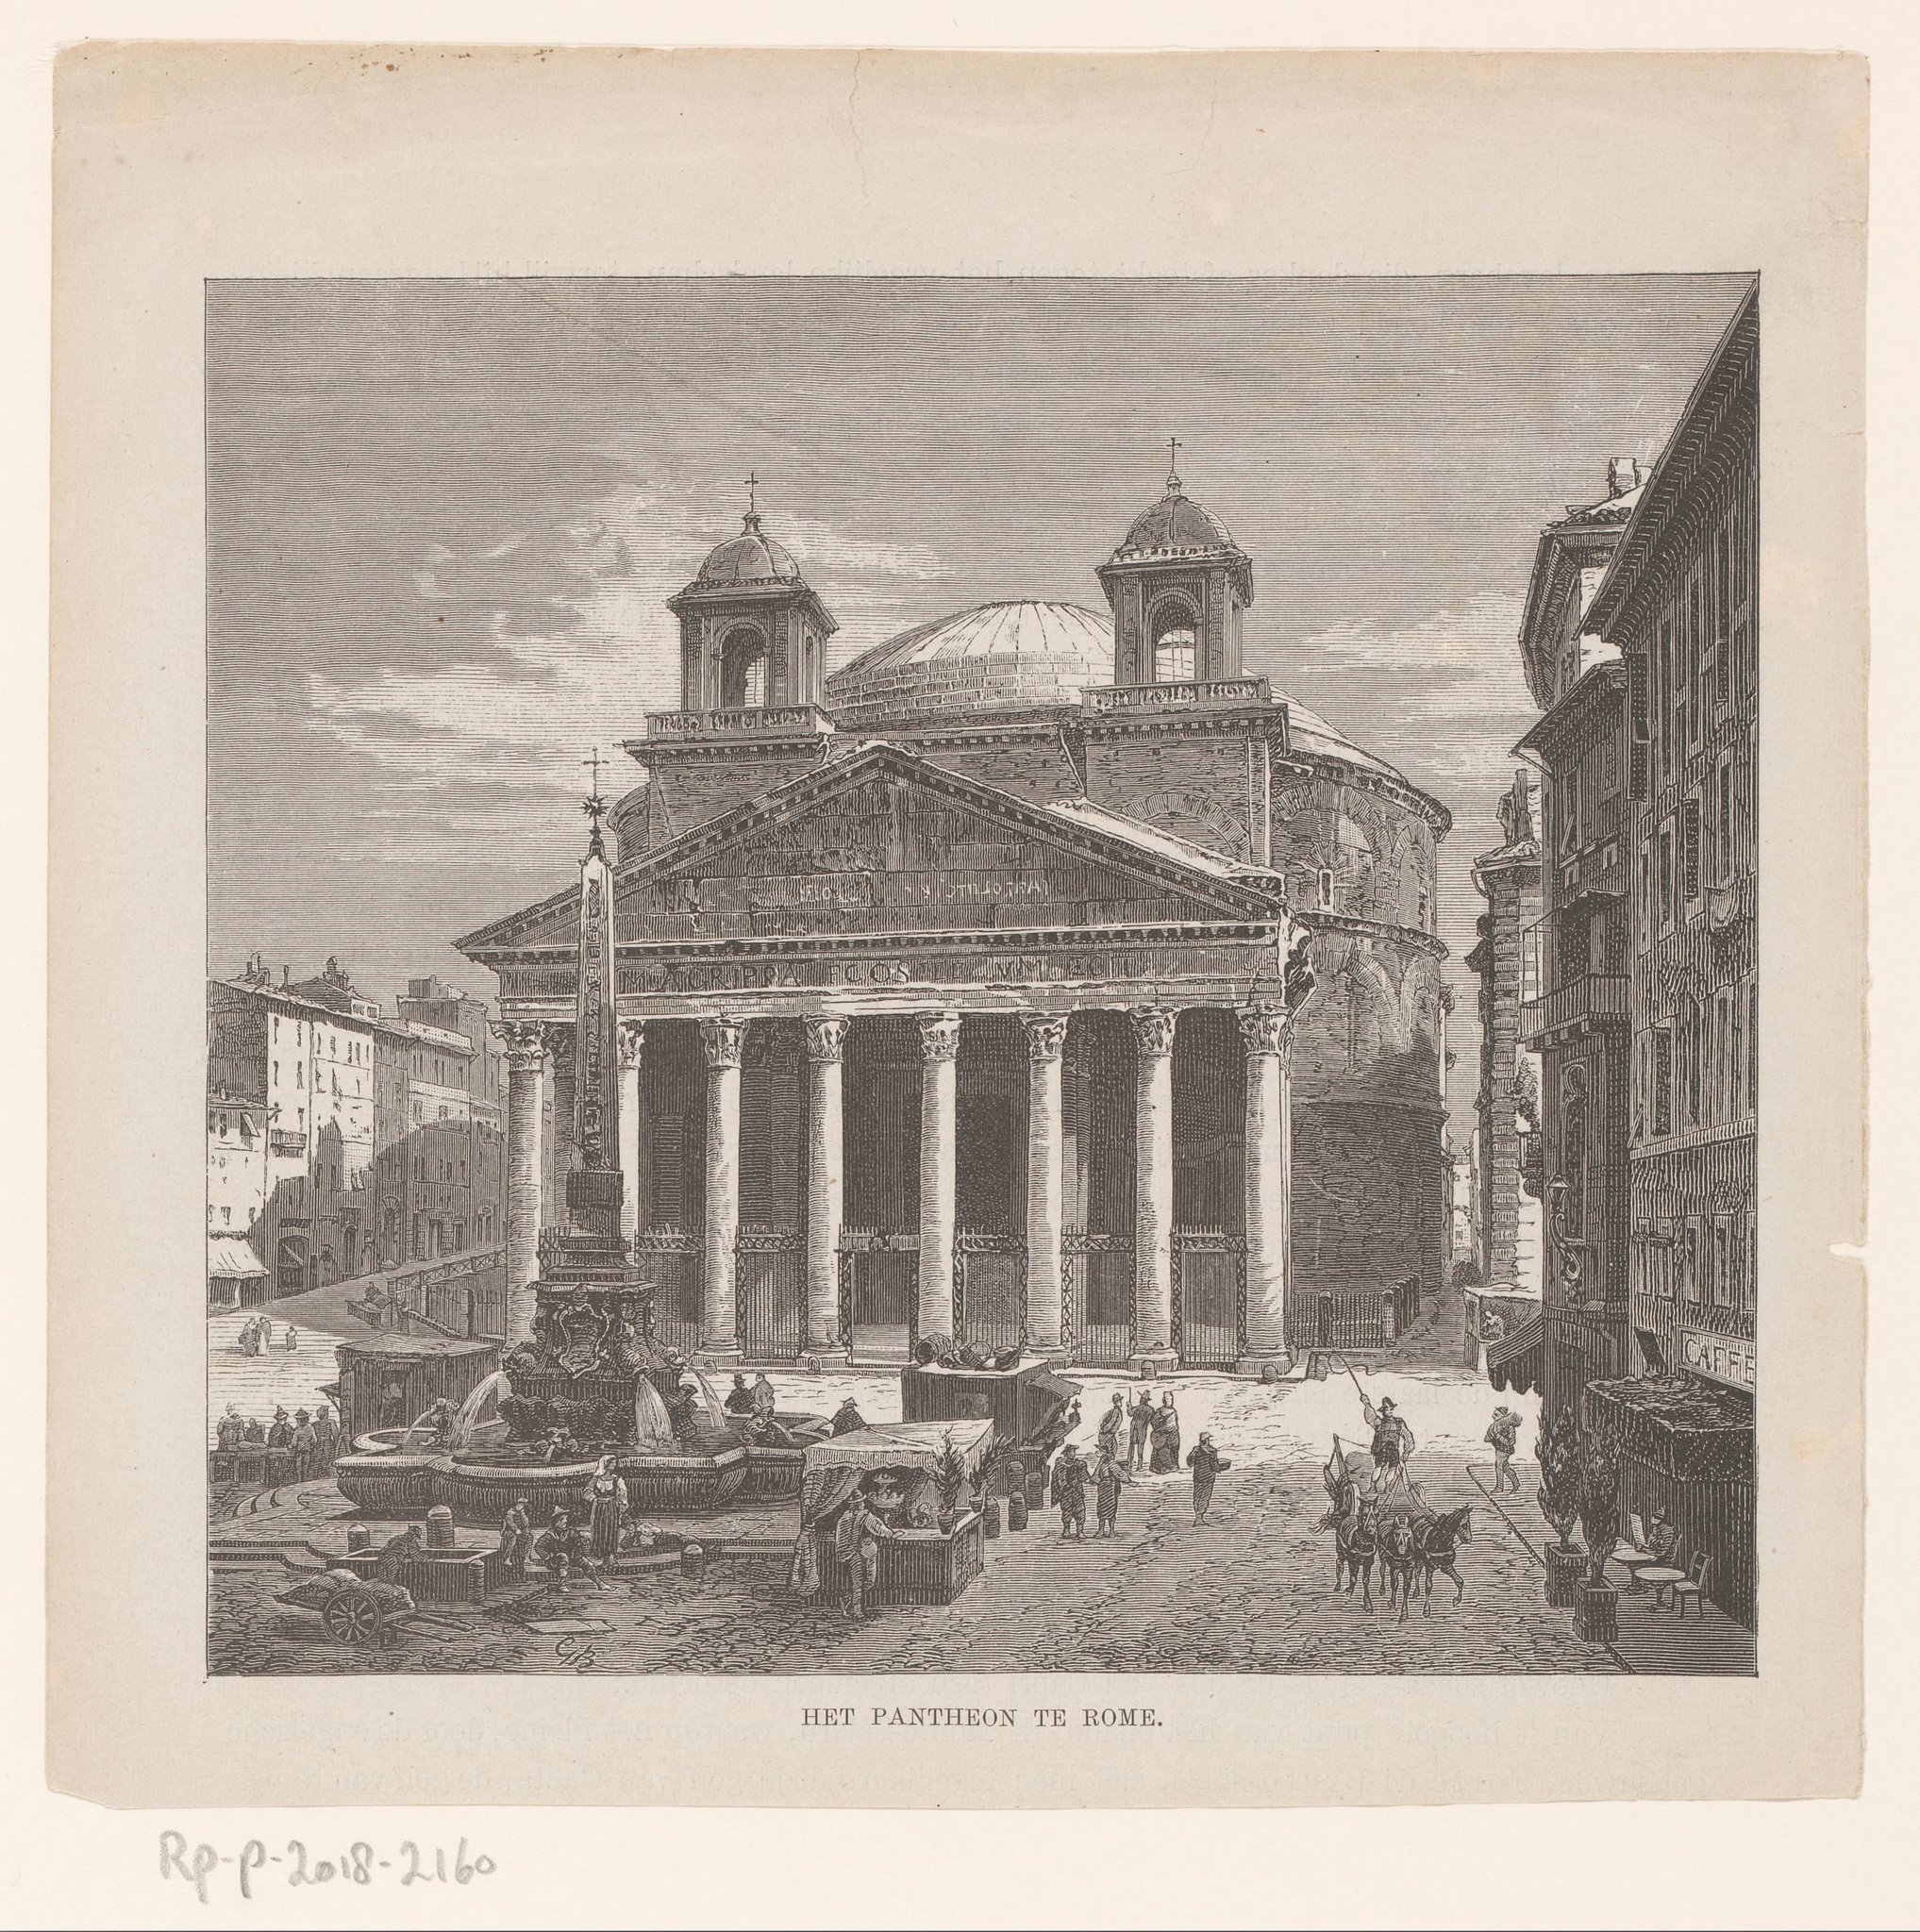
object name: print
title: Gezicht op het Pantheon, te Rome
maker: gustav bauernfeind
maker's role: draughtsman, print maker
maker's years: 1848-1904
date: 1880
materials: paper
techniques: engraving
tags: temple, shrine ~ roman religion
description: Prent gebruikt in: Keller, Gerard. Italié: van de Alpen tot de Etna. S.L.: Sijthoff, 1880.